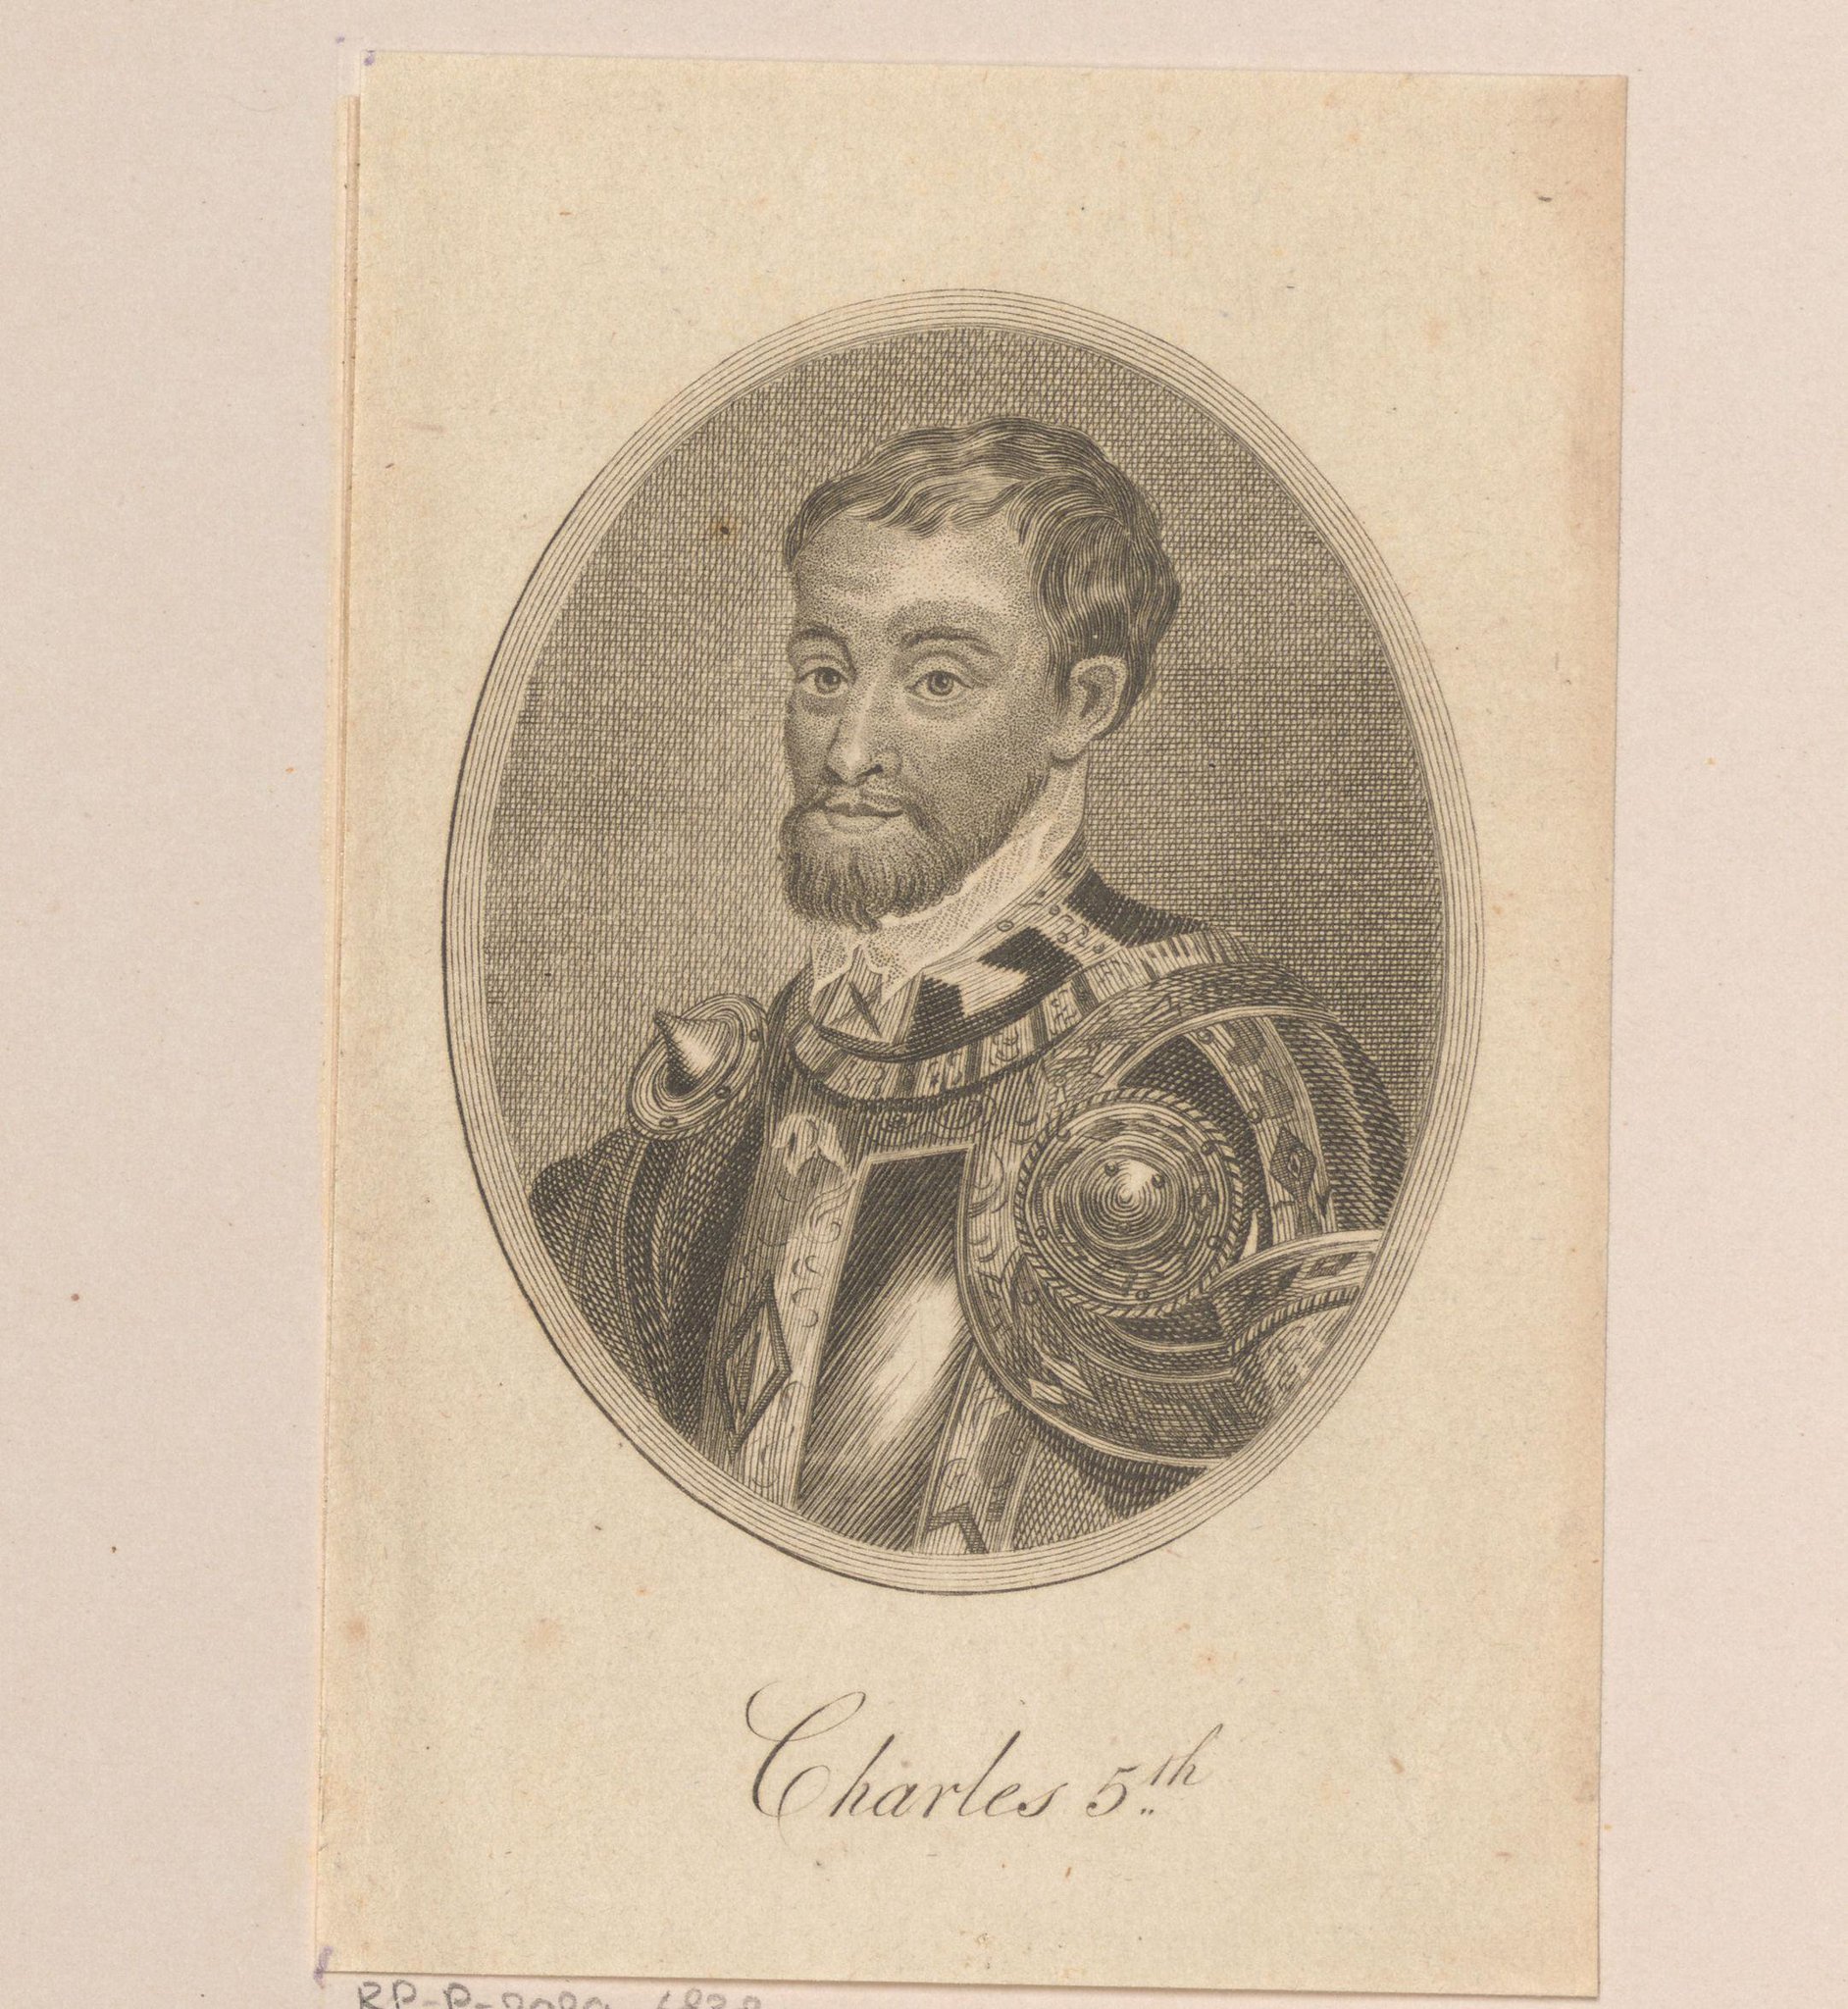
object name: print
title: Portret van keizer Karel V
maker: Anonymous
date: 1700-1799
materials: paper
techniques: engraving, letterpress printing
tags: ghent, charles v (holy roman emperor and king of spain), harness, historical persons, knighthood order of the golden fleece, king